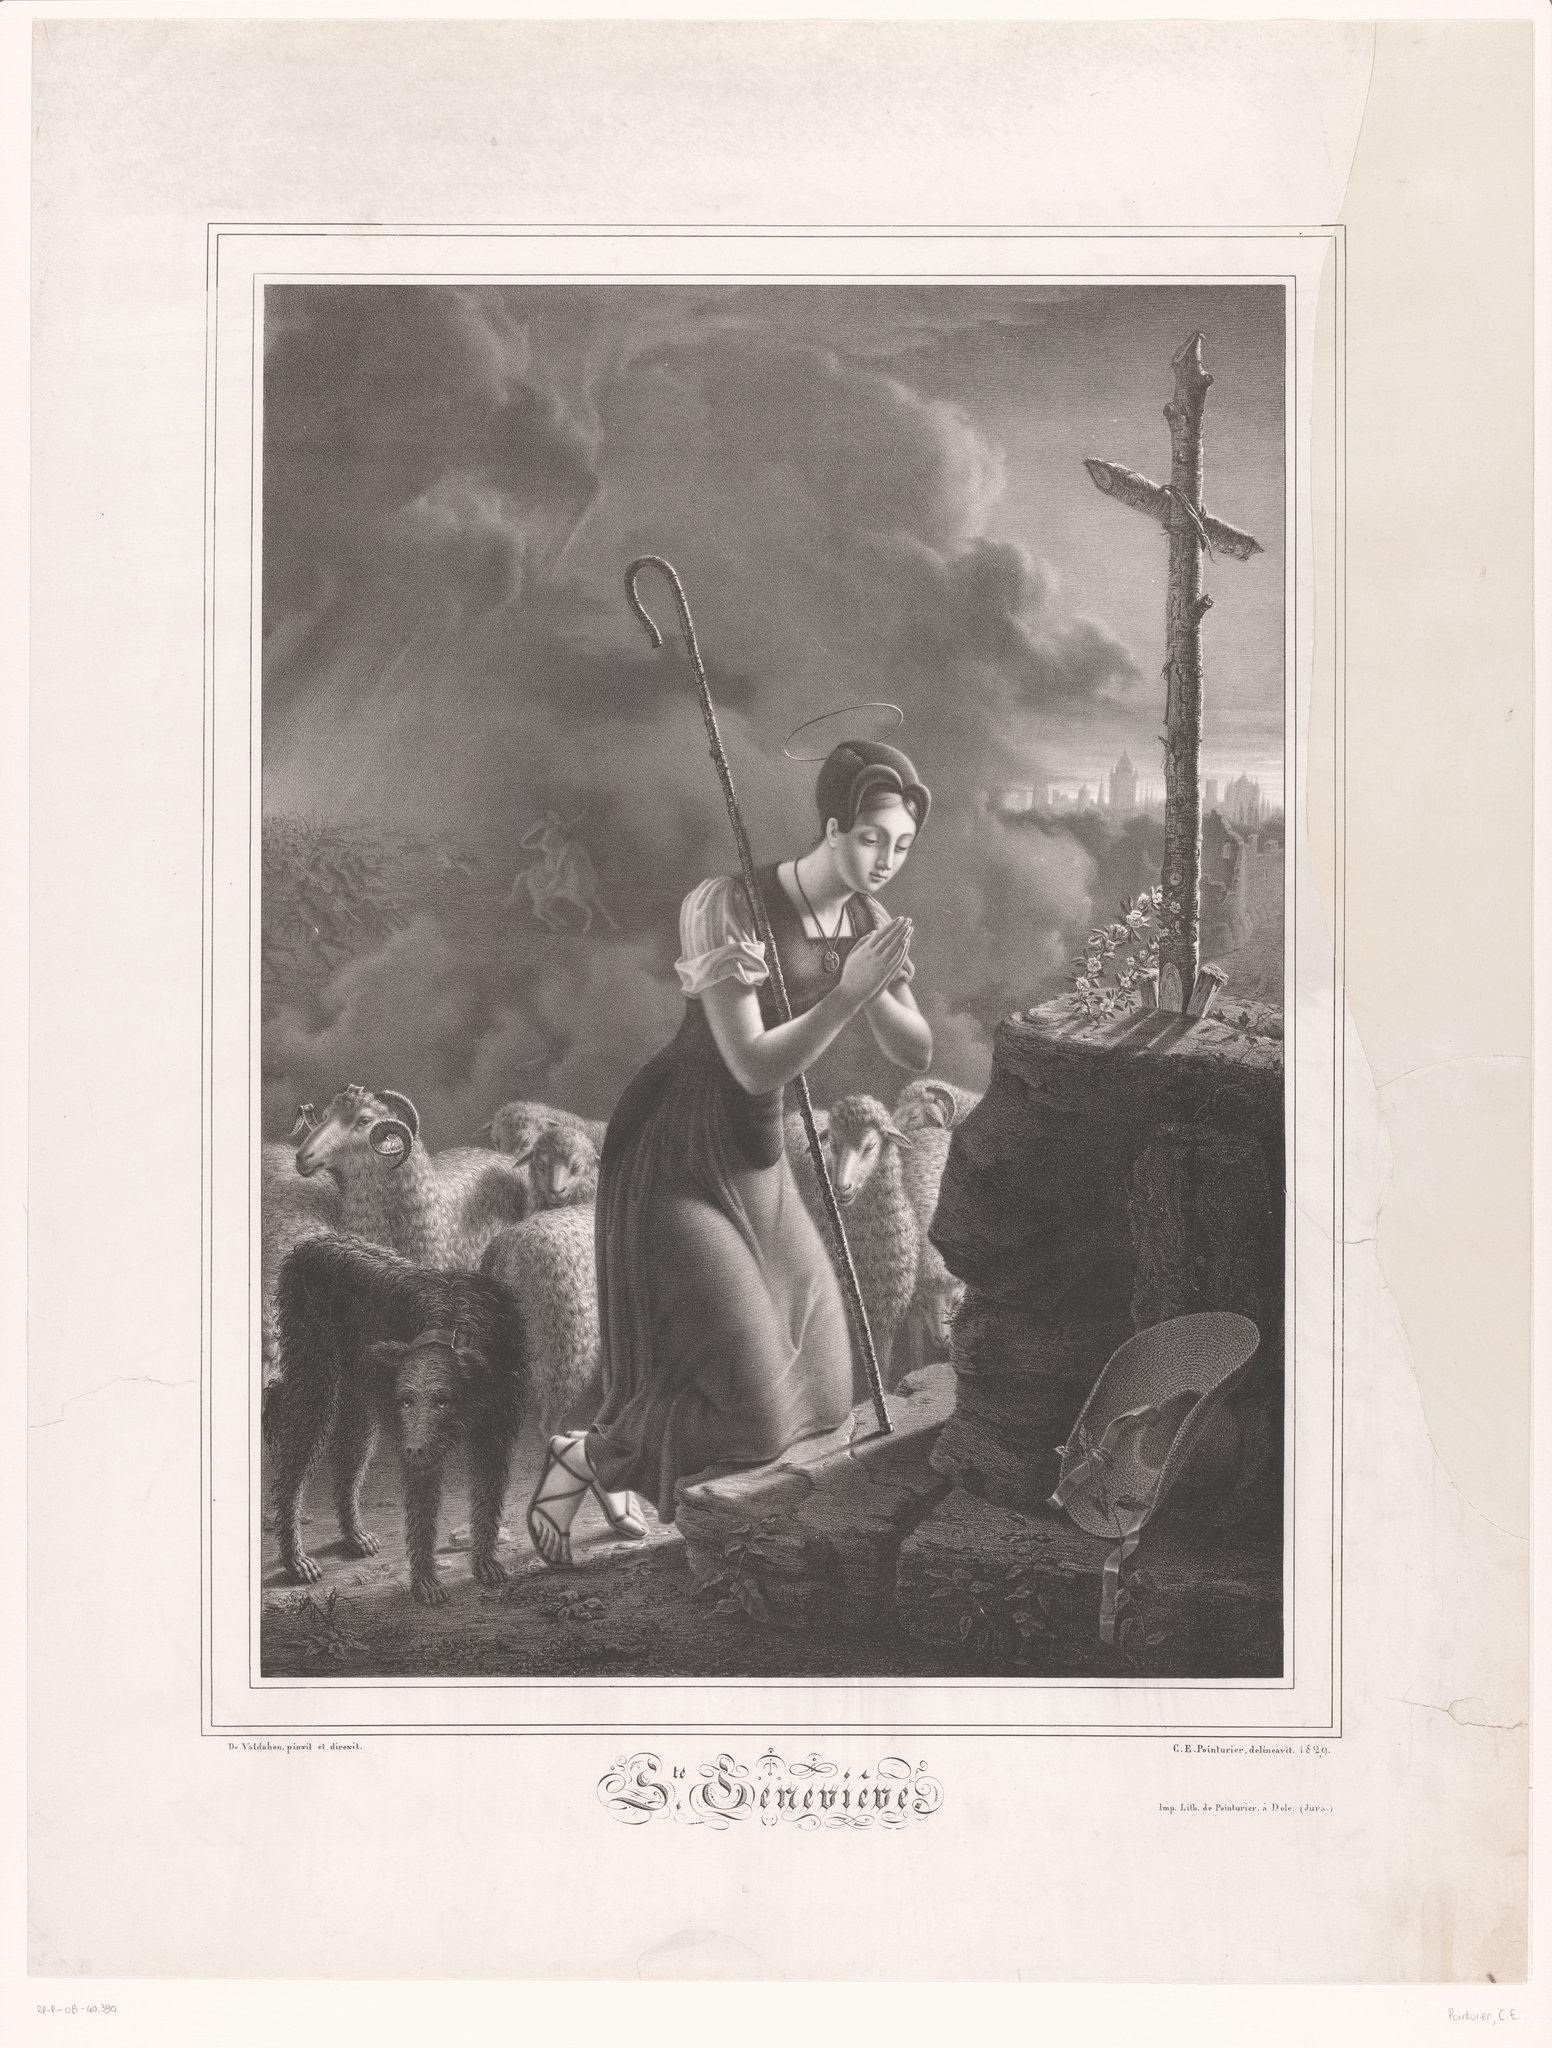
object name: print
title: Heilige Genoveva van Parijs als herderin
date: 1829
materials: paper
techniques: lithograph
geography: dole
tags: st. genevieve as shepherdess, keeping her sheep and spinning, sheep, dog, the virgin genevieve (genofeva, genovefa); possible attributes: angel, book, candle (or taper), crown, crook, demon, distaff, medallion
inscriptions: collector's mark: Lugt 2228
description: Op de achtergrond is Atilla de Hun samen met zijn leger afgebeeld. Door het bidden en boete doen van de heilige Geneviève wordt de aanval op Parijs afgewend.